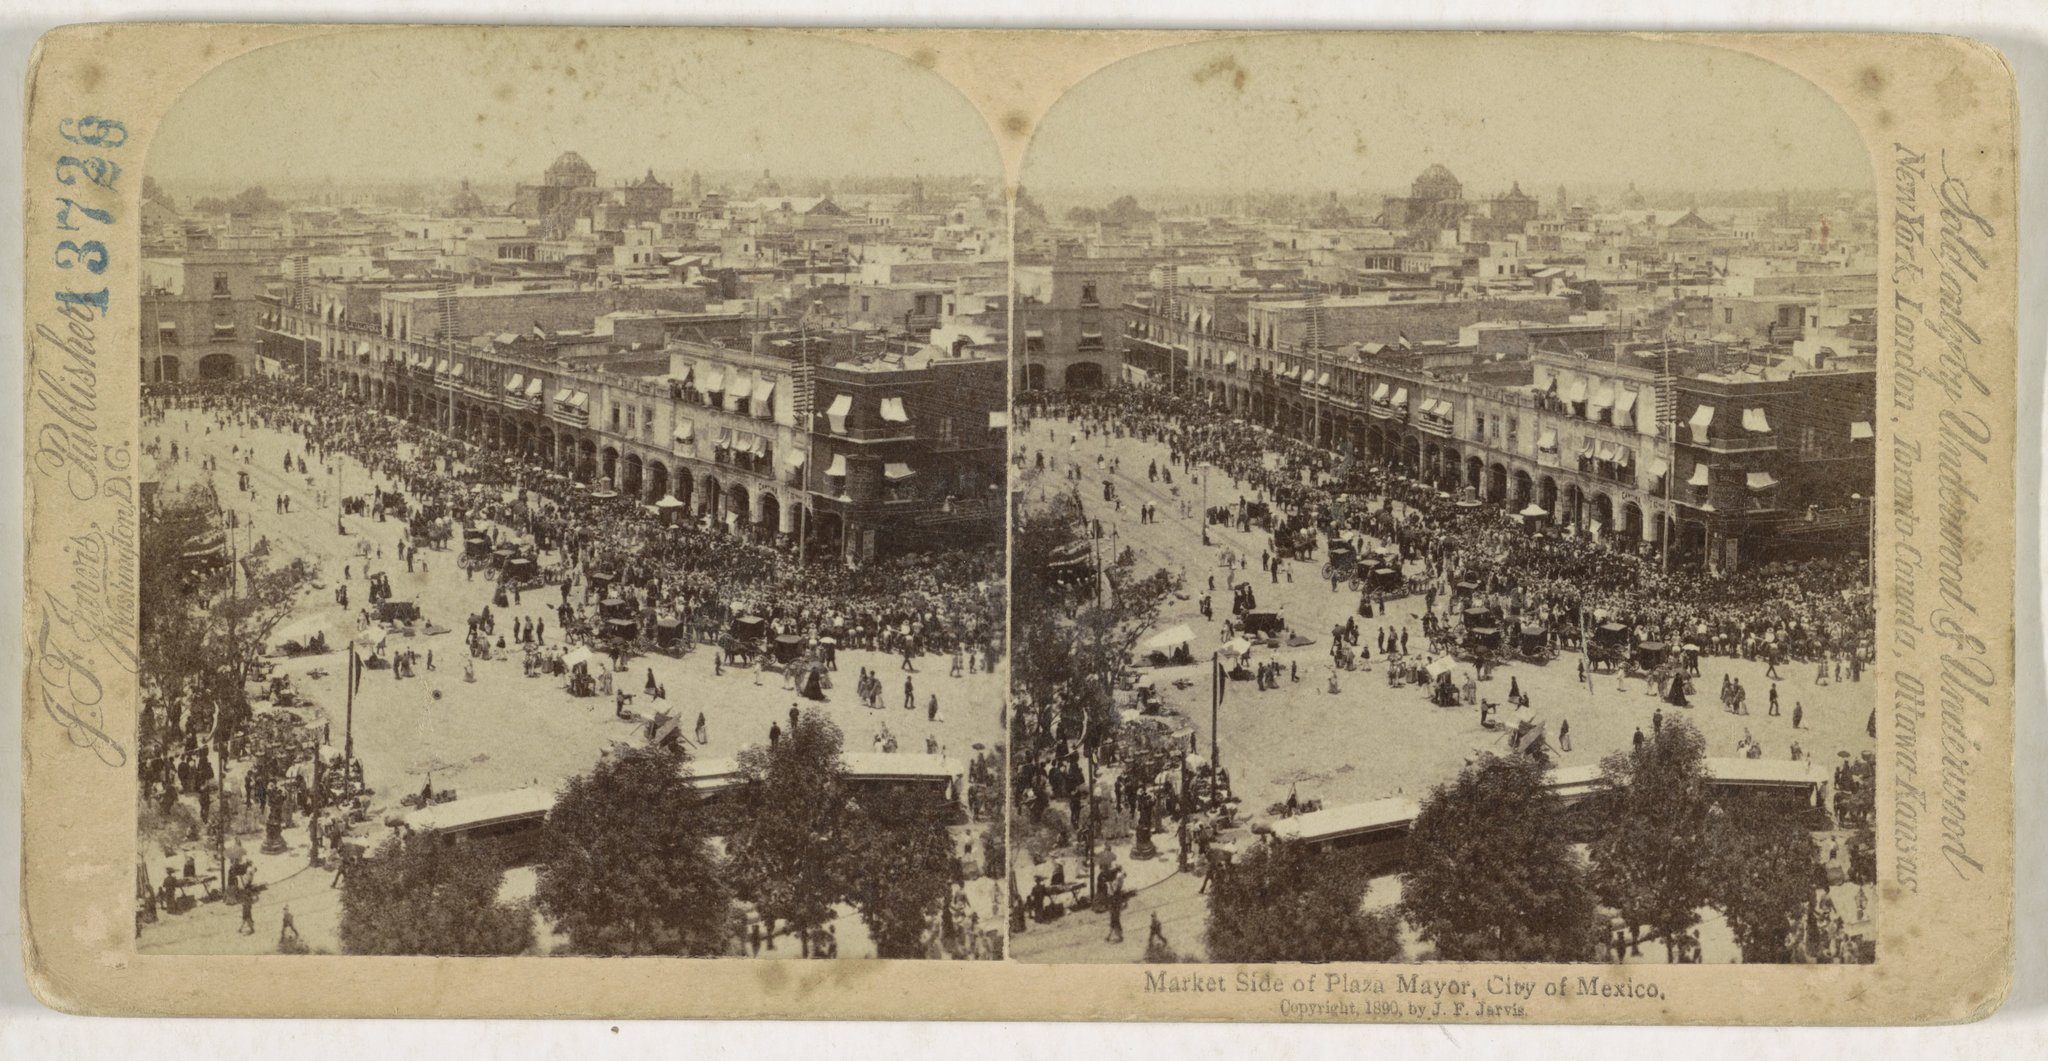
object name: stereograph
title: Parade op het Plaza de la Constitución, Mexico-Stad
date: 1890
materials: cardboard, paper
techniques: albumen print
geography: new york city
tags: square, place, circus, etc.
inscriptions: inscription: ‘P. 85.’, copyright notice: ‘Copyright 1890, by J. F. Jarvis.’, number: ‘13726’